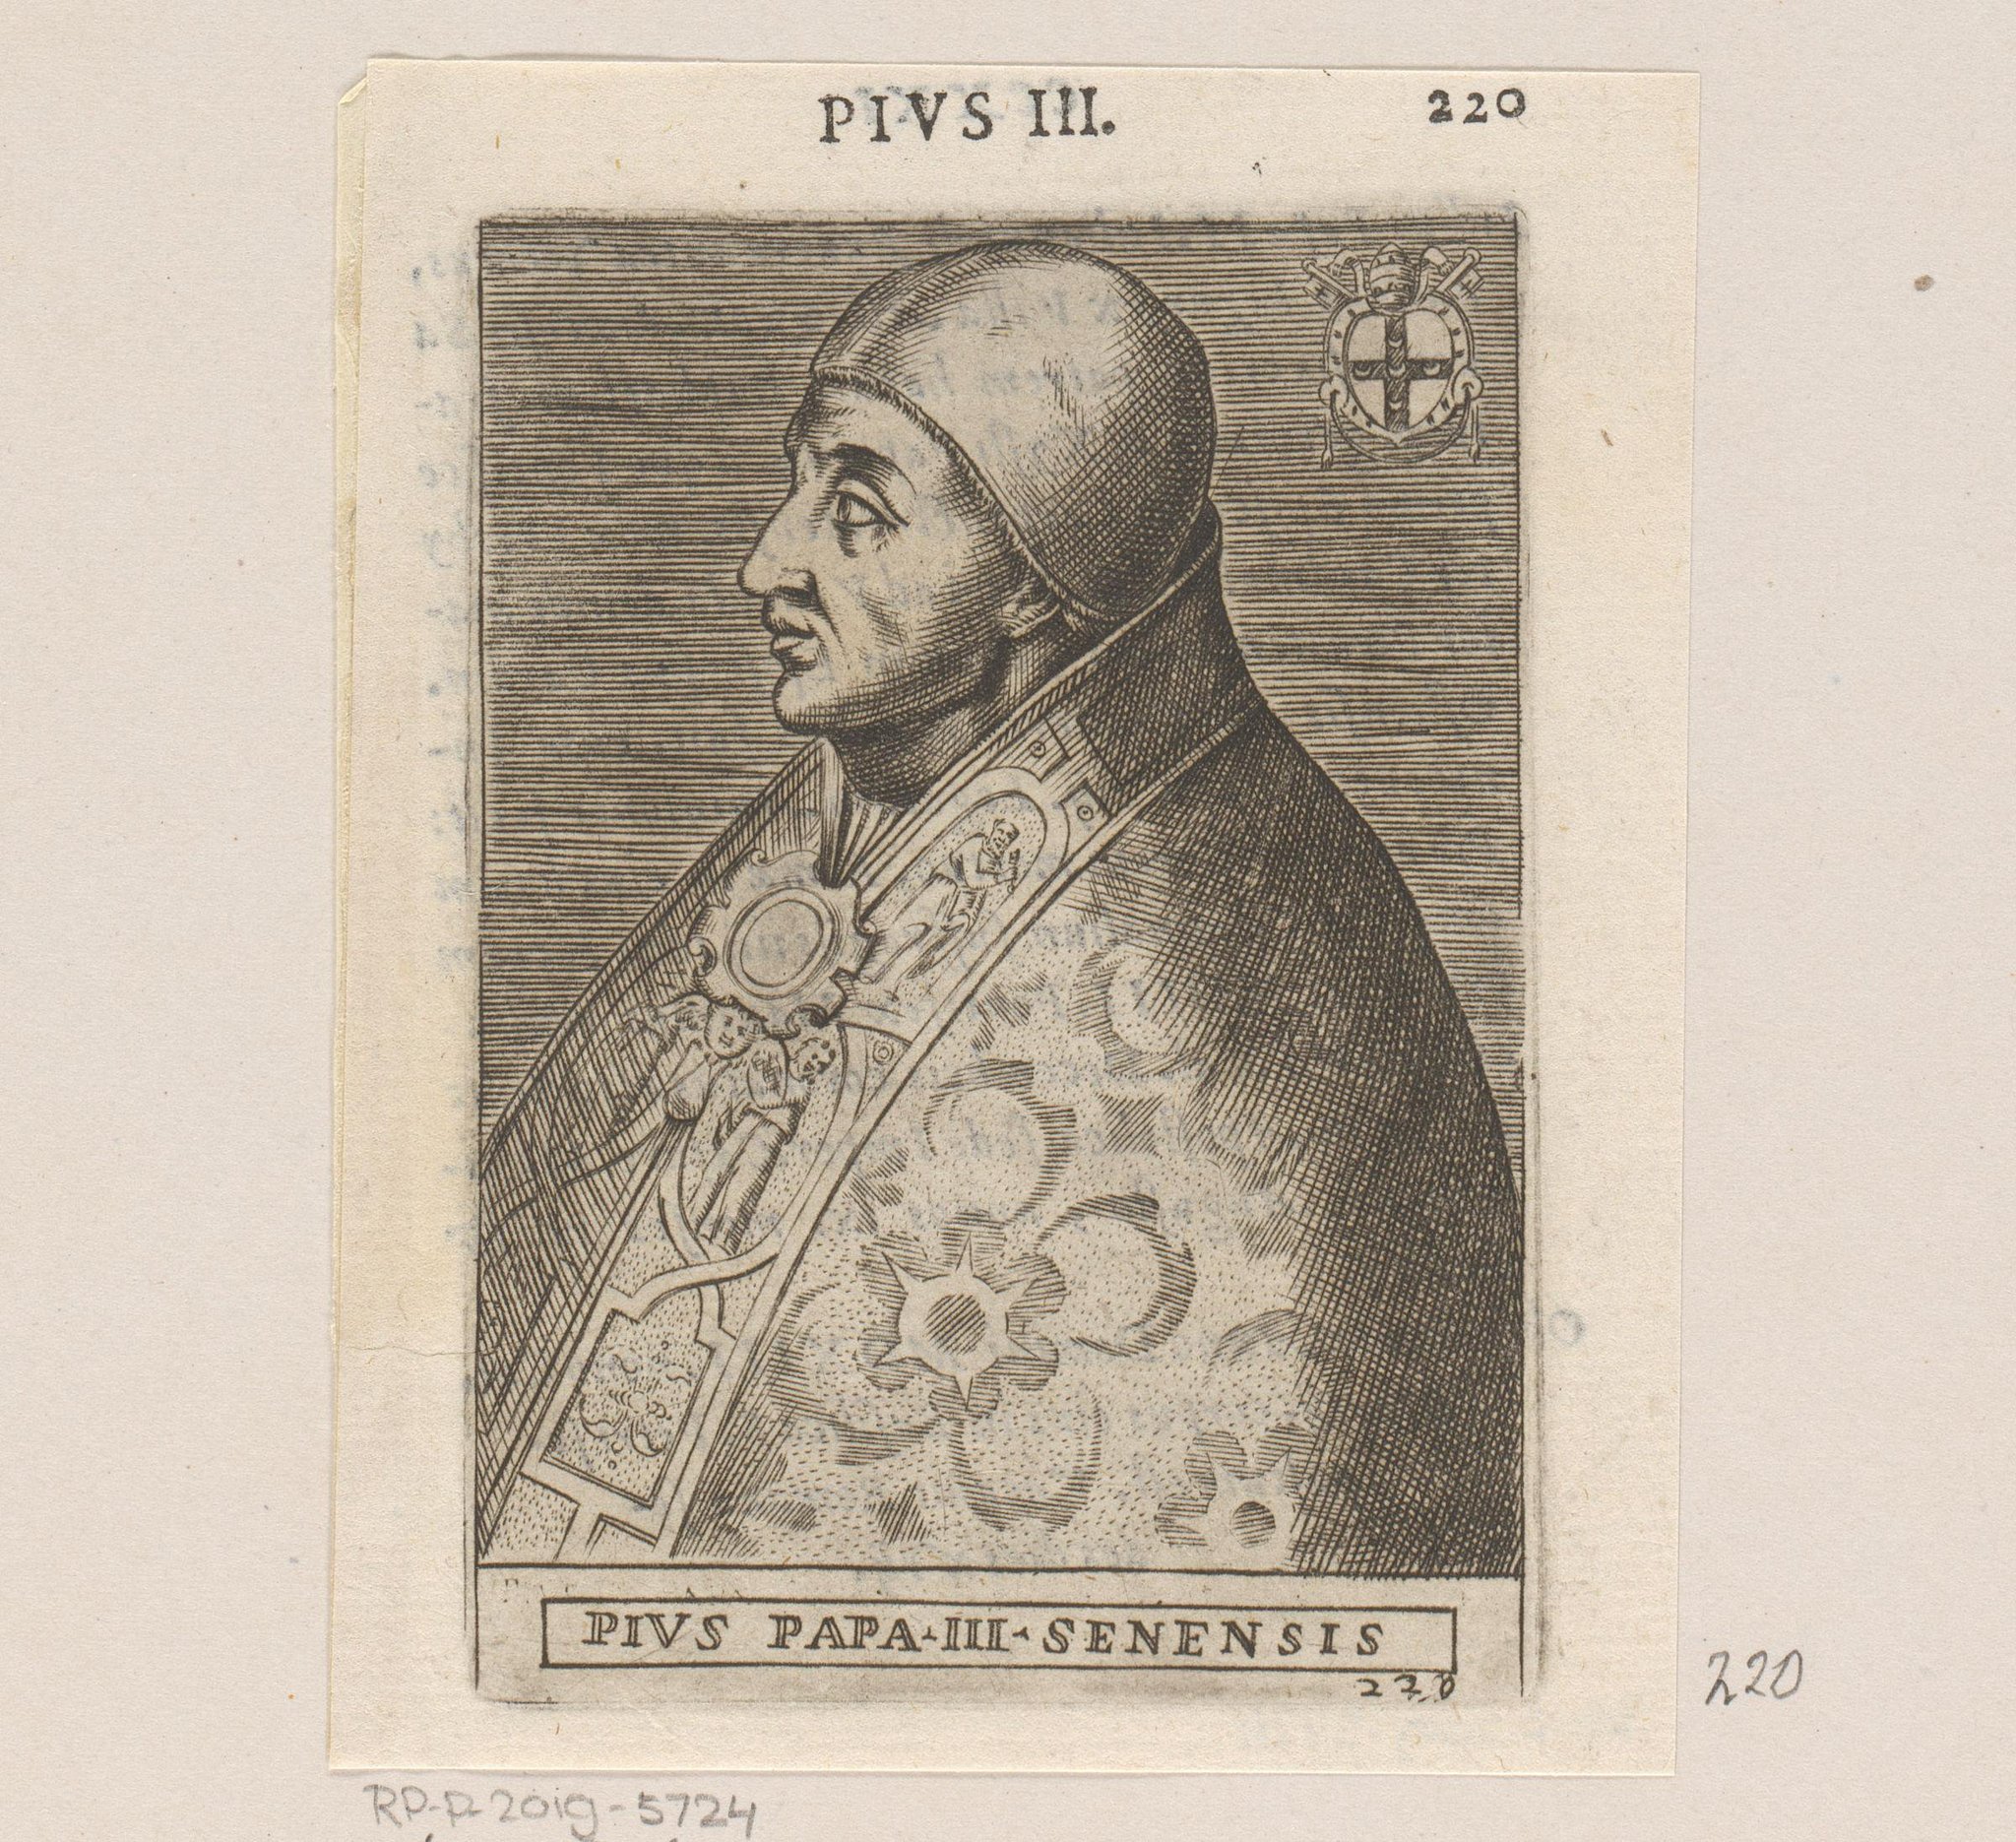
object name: book illustration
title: Portret van paus Pius III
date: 1595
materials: paper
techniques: engraving, letterpress printing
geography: rome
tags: historical persons, pope, armorial bearing, heraldry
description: Prent uit: Cavalieri, Giovanni Battista de'. Effigies pontificum romanorum cum eorum vitis (...). Rome: Bartolomeo Bonfadino, 1595. Prent voor het eerst verschenen in: Cavalieri, Giovanni Battista de'. Pontificum romanorum effigies (...). Rome: Domenico Basa en Francesco Zanetti, 1580. Prent ook gebruikt in latere publicaties.